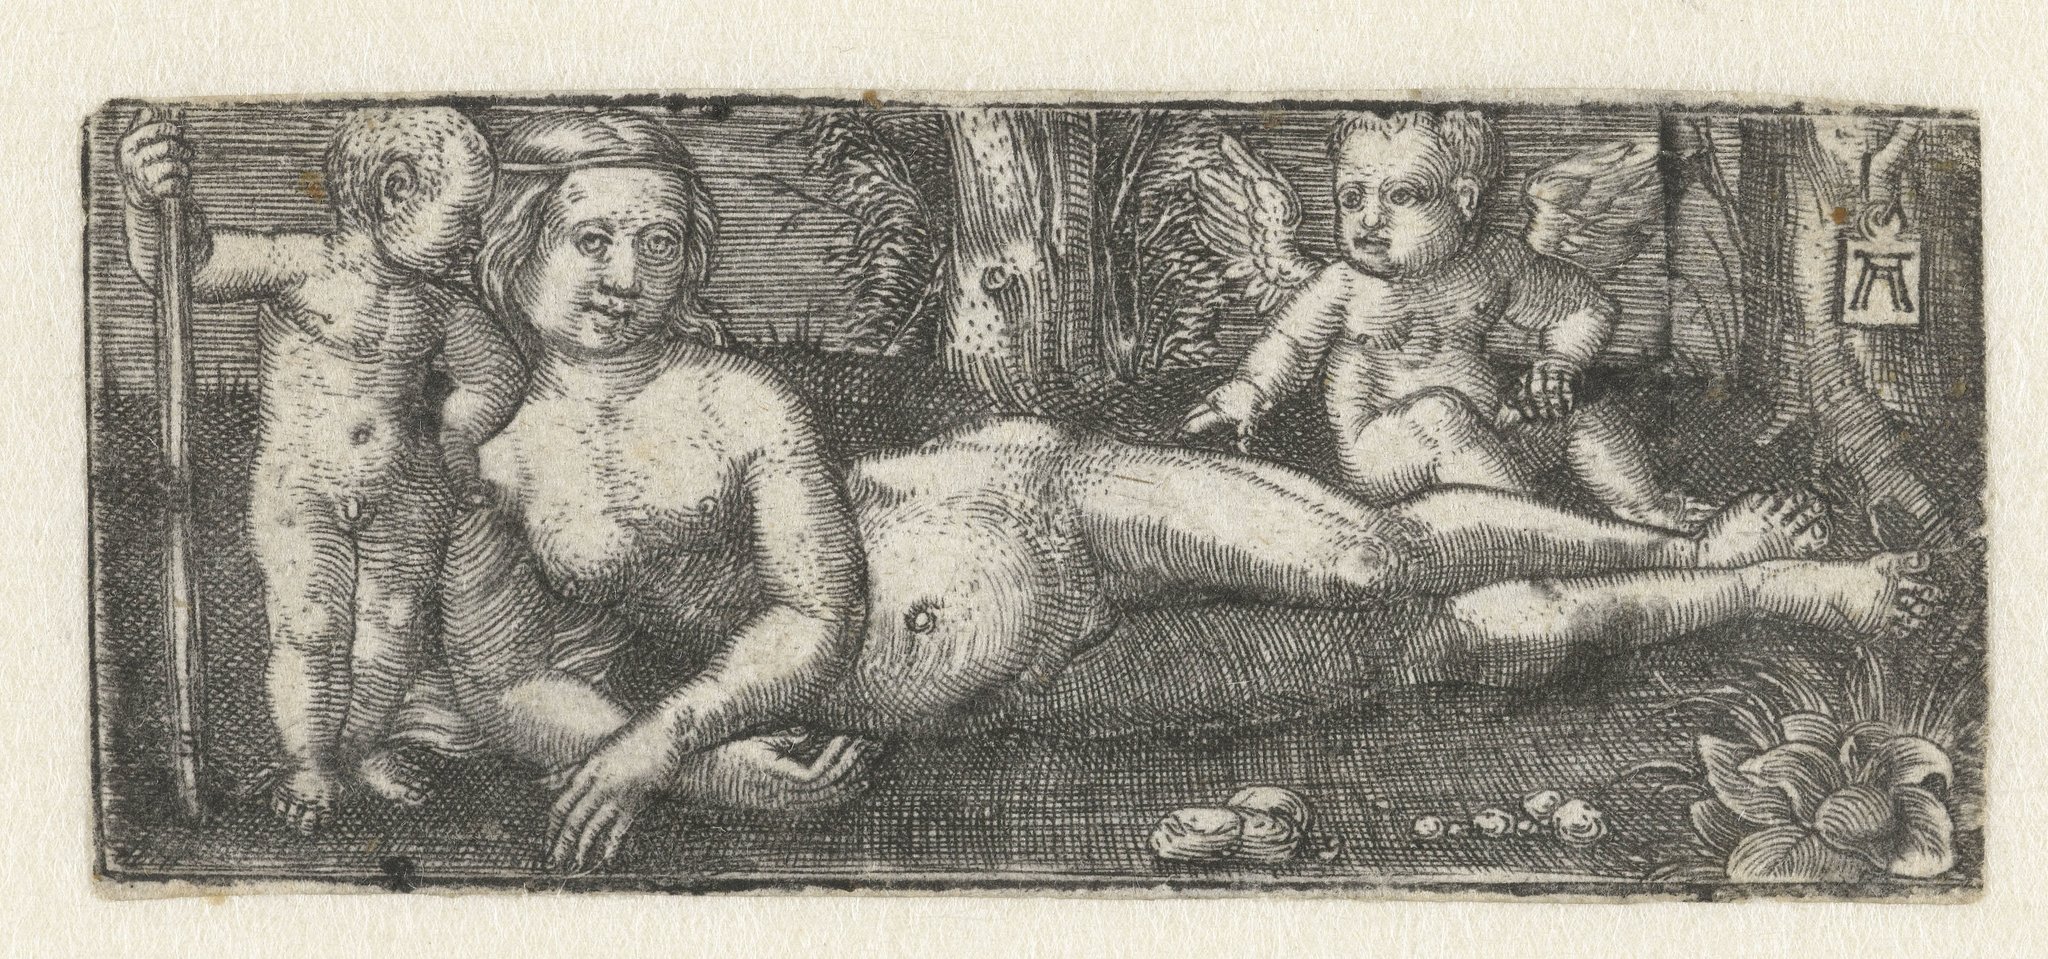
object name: print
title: Liggende Venus met twee putti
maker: albrecht altdorfer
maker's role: draughtsman, print maker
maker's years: 1480-1538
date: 1506-1538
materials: paper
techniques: engraving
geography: germany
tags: (story of) venus (aphrodite), cupids: 'amores', 'amoretti', 'putti'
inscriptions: number: ‘8’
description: Venus, naakt en liggend op het gras, bij haar zijn twee putti, waarvan één met vleugels.